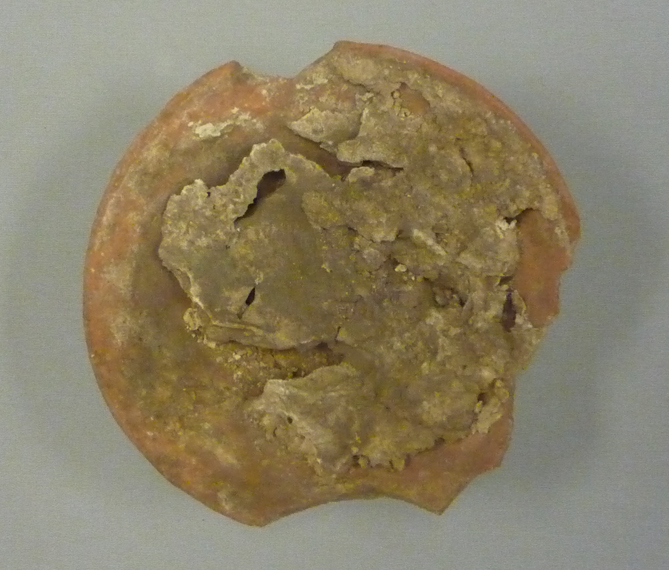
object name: bowl, resin or butter, foundation deposit, hatshepsut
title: Bowl Containing Resin and Butter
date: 1479-1458 BCE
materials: pottery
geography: egypt